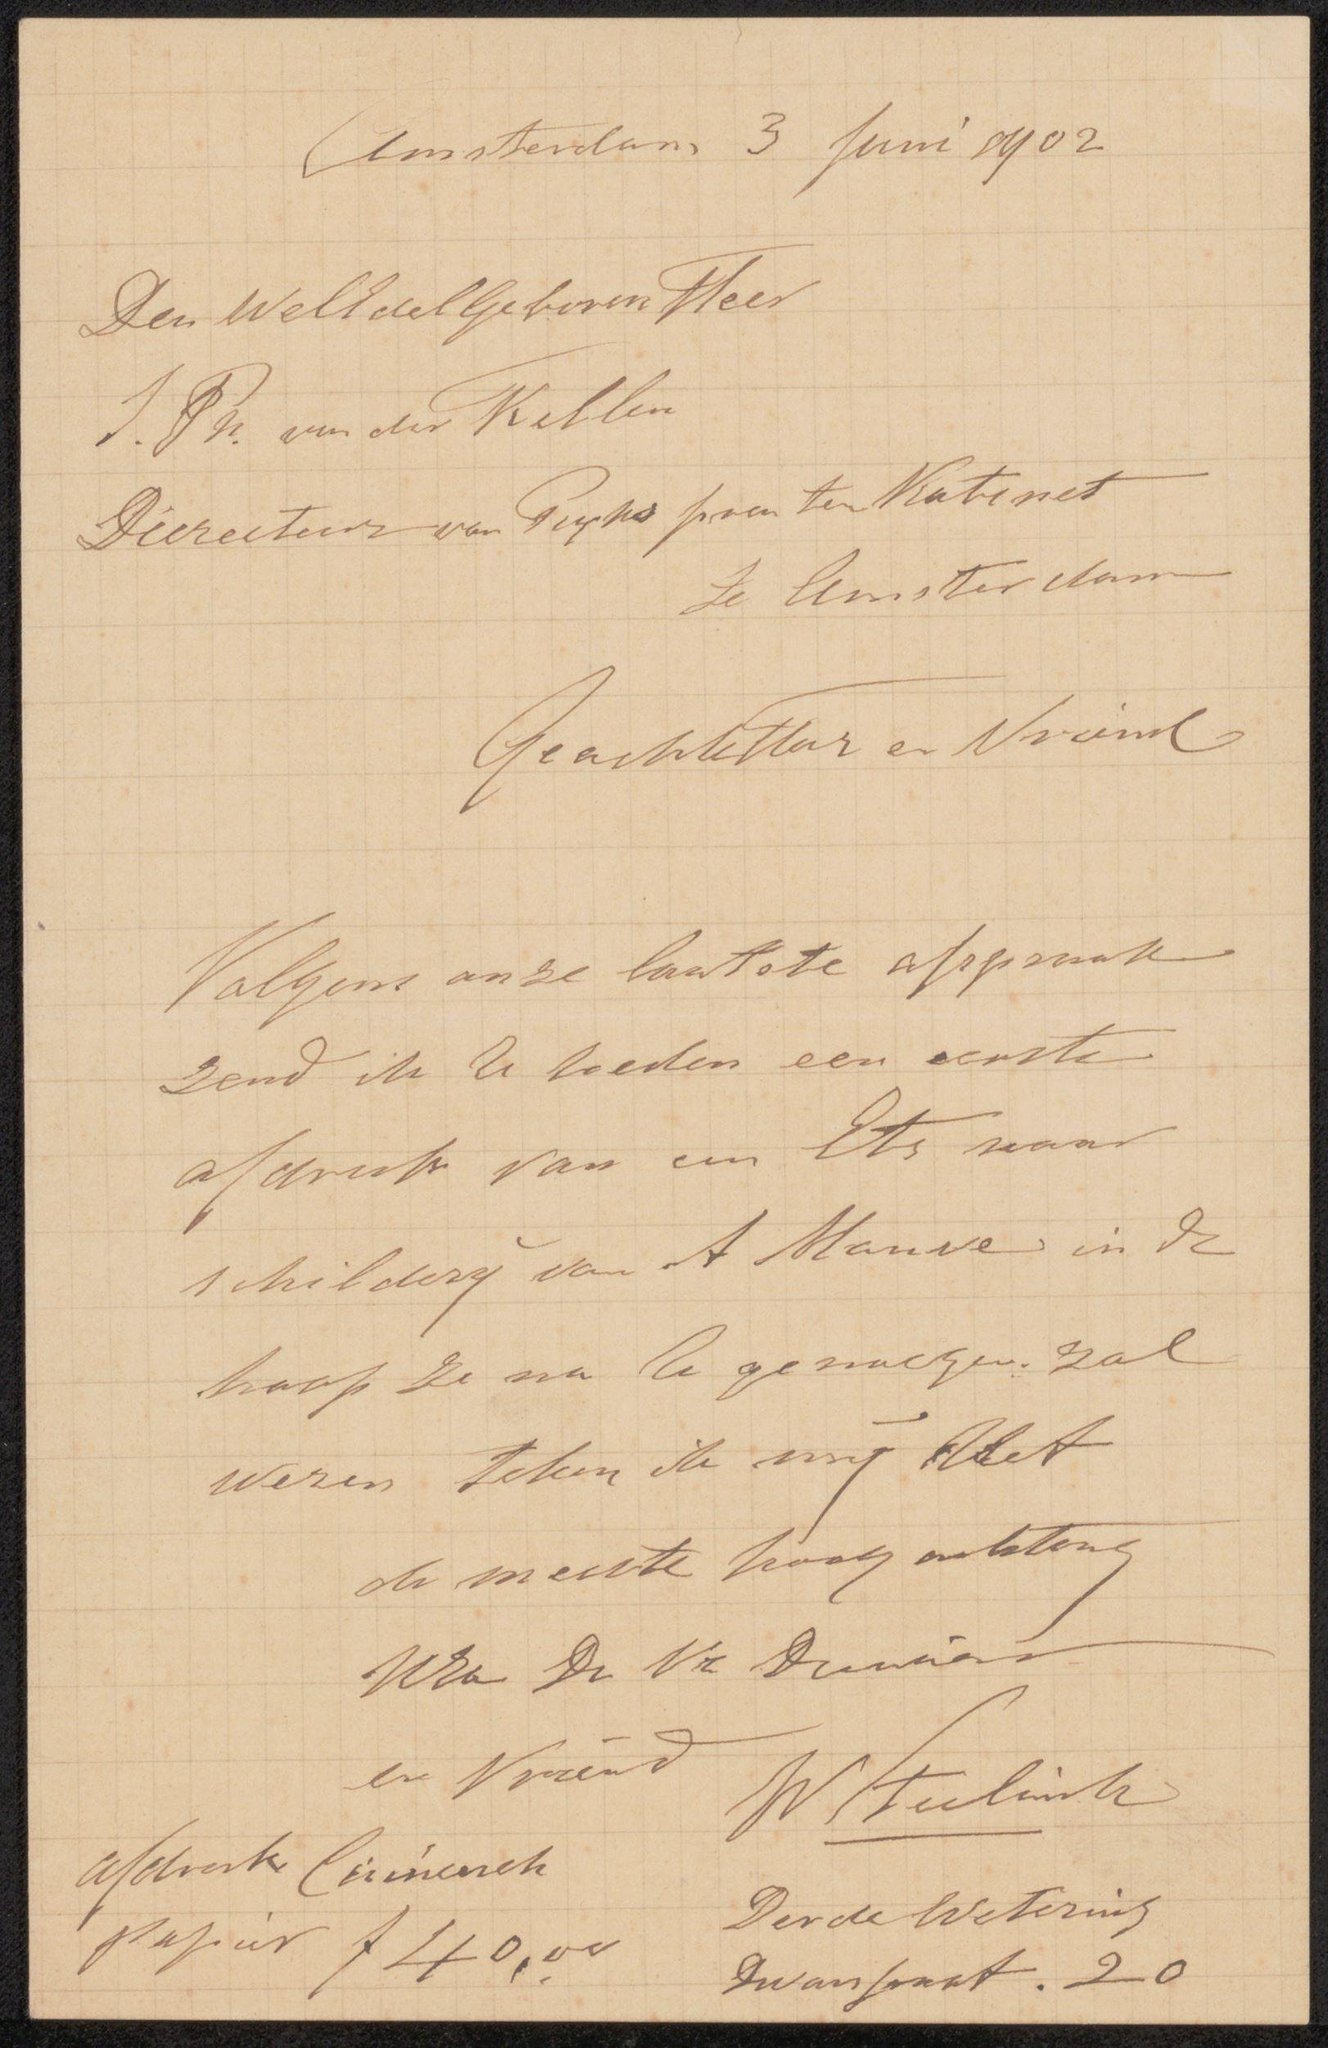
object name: letter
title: Brief aan Johan Philip van der Kellen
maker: willem steelink (i)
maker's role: draughtsman, print maker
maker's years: 1826-1913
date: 1902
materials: ink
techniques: pen, writing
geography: amsterdam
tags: utrecht, johan philip van der kellen, arnhem, painter, print maker, draughtsman, anton mauve, the graphic arts, money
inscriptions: watermark